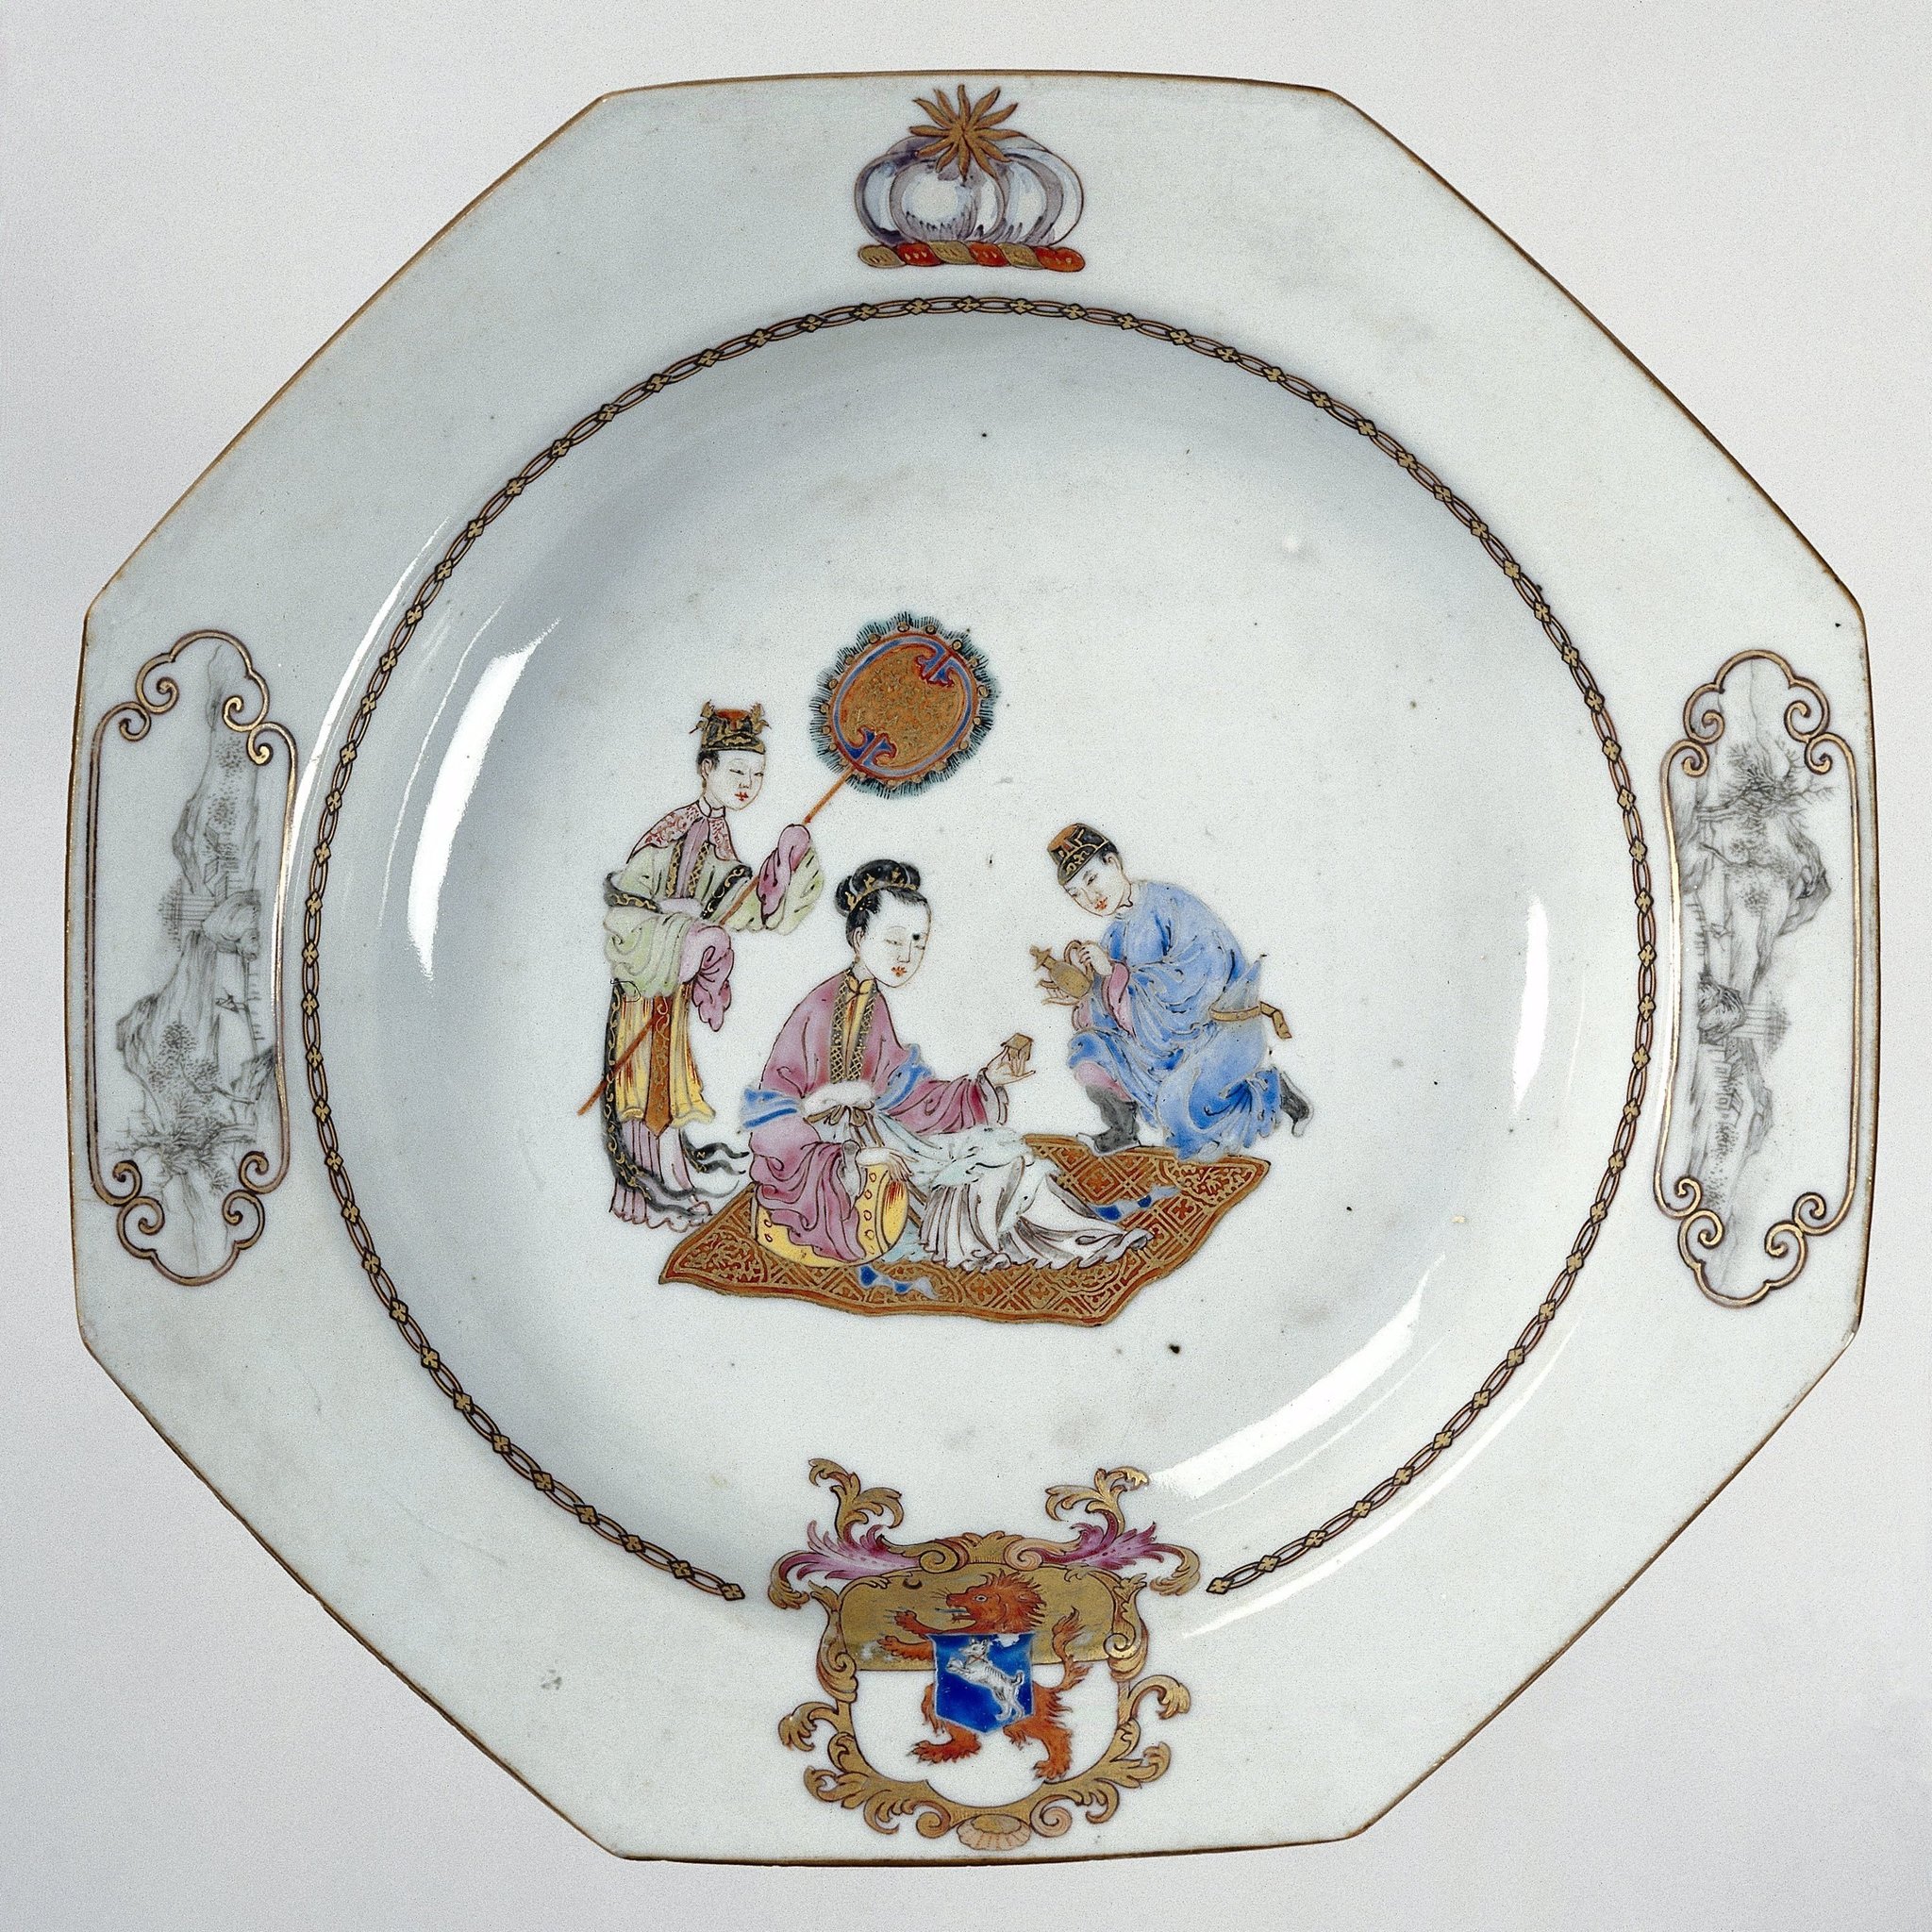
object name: plate dish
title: Octagonal soupplate with a seated woman with two servants and on the side the arms of the Powell family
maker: Anonymous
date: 1750-1774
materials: glaze, gold, paint, porcelain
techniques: firing, forming, gilding, turning, vitrification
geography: china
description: Achthoekig soepbord van porselein, beschilderd op het glazuur in blauw, rood, roze, groen, geel, zwart en goud. Op het plat een zittende vrouw met twee bedienden. Op de wand een band met schakelpatroon onderbroken door het wapen van de familie Powell, een leeuw tegen een gouden en witte achtergrond met als hartschild het wapen van de familie Cleland, een haas tegen een blauwe achtergrond. Het wapen is omgeven door bladranken; het helmteken op de rand aan de overzijde. Op de rand twee cartouches met een landschap in encre de Chine. Enkele chips in de rand. Wapenporselein met emailkleuren.